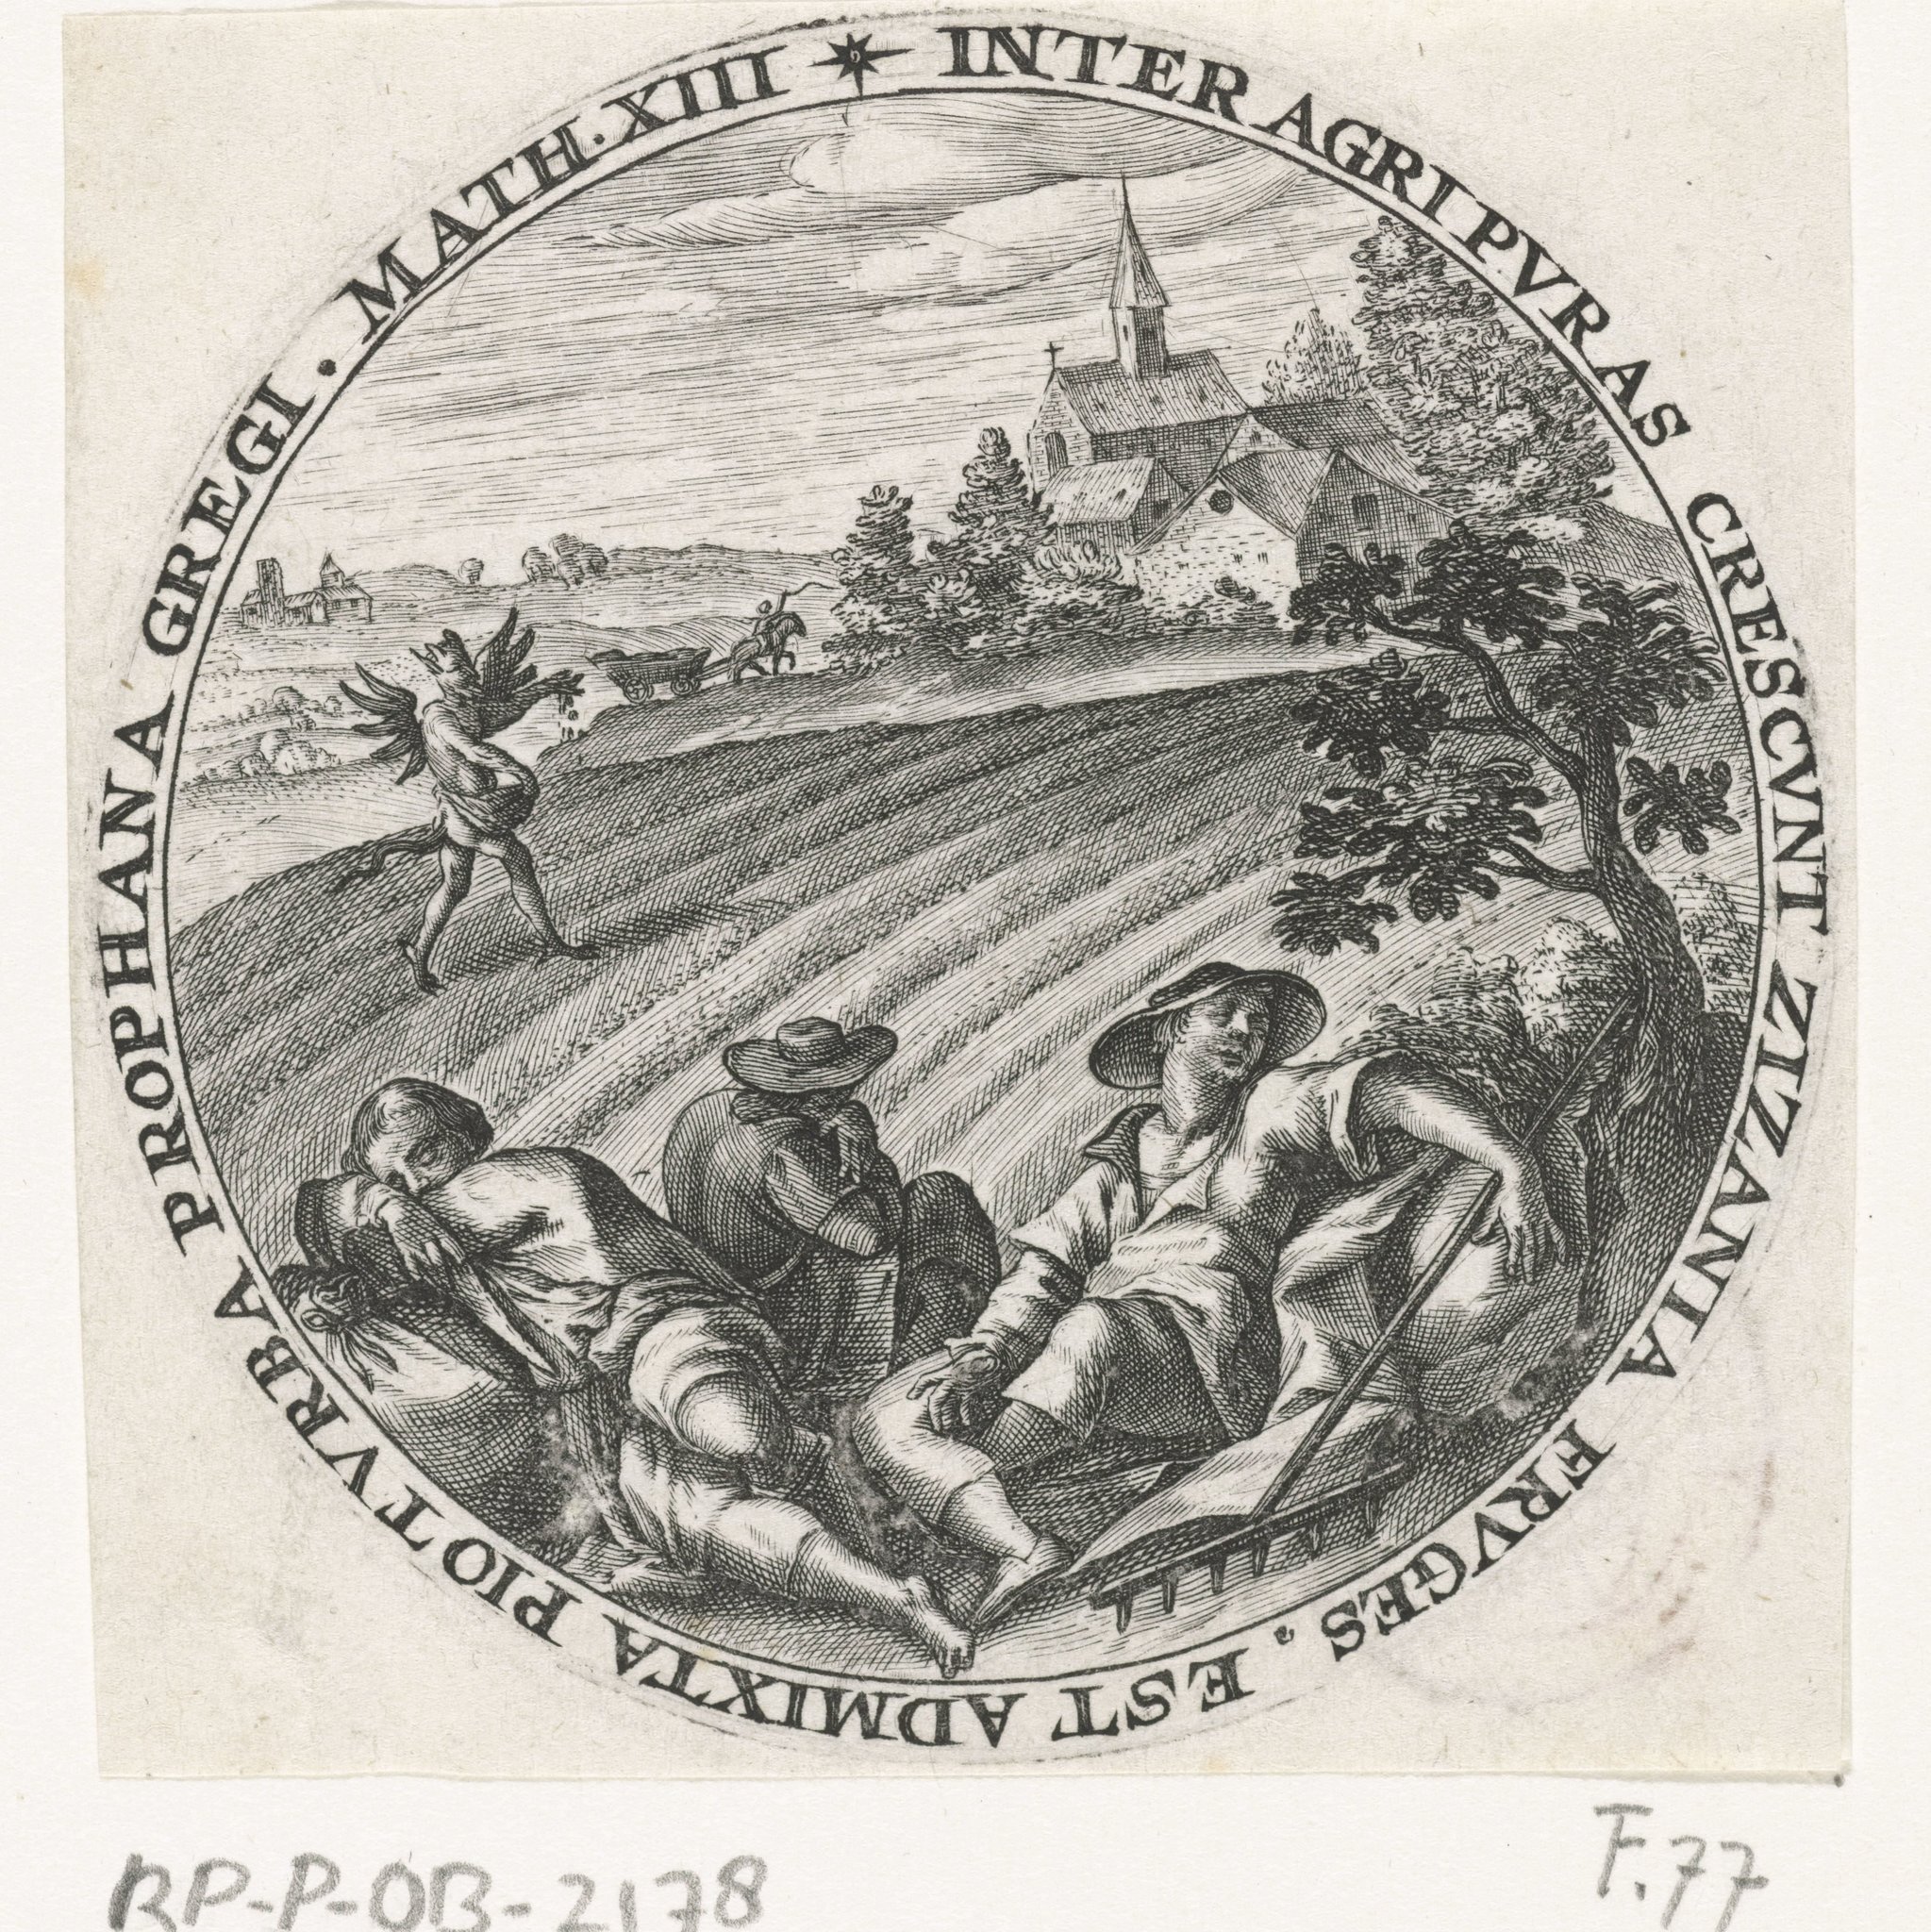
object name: print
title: Parabolarum Evagelicaru Typi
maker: crispijn van de passe (i)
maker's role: draughtsman, print maker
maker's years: 1564-1637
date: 1604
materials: paper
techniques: engraving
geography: cologne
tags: while the sower and his servants slept, his enemy (the devil) sowed tares among the wheat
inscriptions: collector's mark: Lugt 240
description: Terwijl de mensen slapen op hun akker zaait de duivel onkruid tussen het graan (Mat. 10; 24-29). De voorstelling is gevat in een ronde omlijsting met een randschrift in het Latijn. Prent uit een serie met gelijkenissen van Christus.